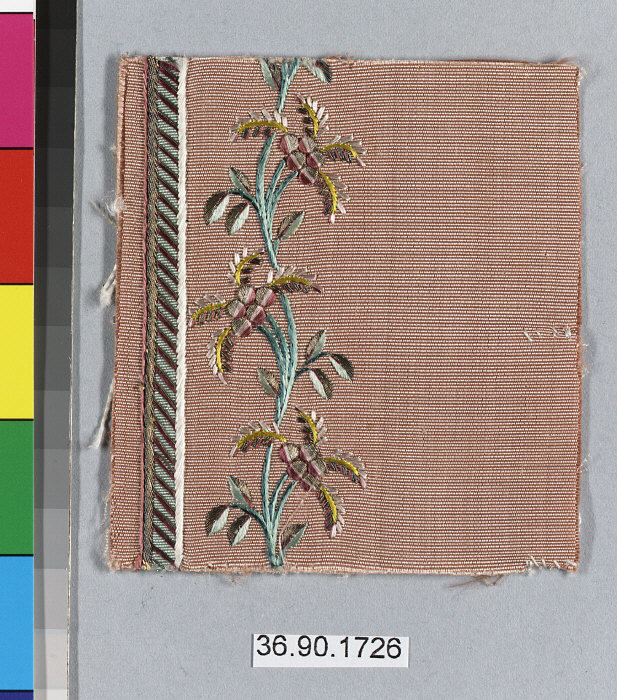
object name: sample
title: Embroidery sample for a man’s suit or waistcoat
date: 1785-1815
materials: metal thread, silk